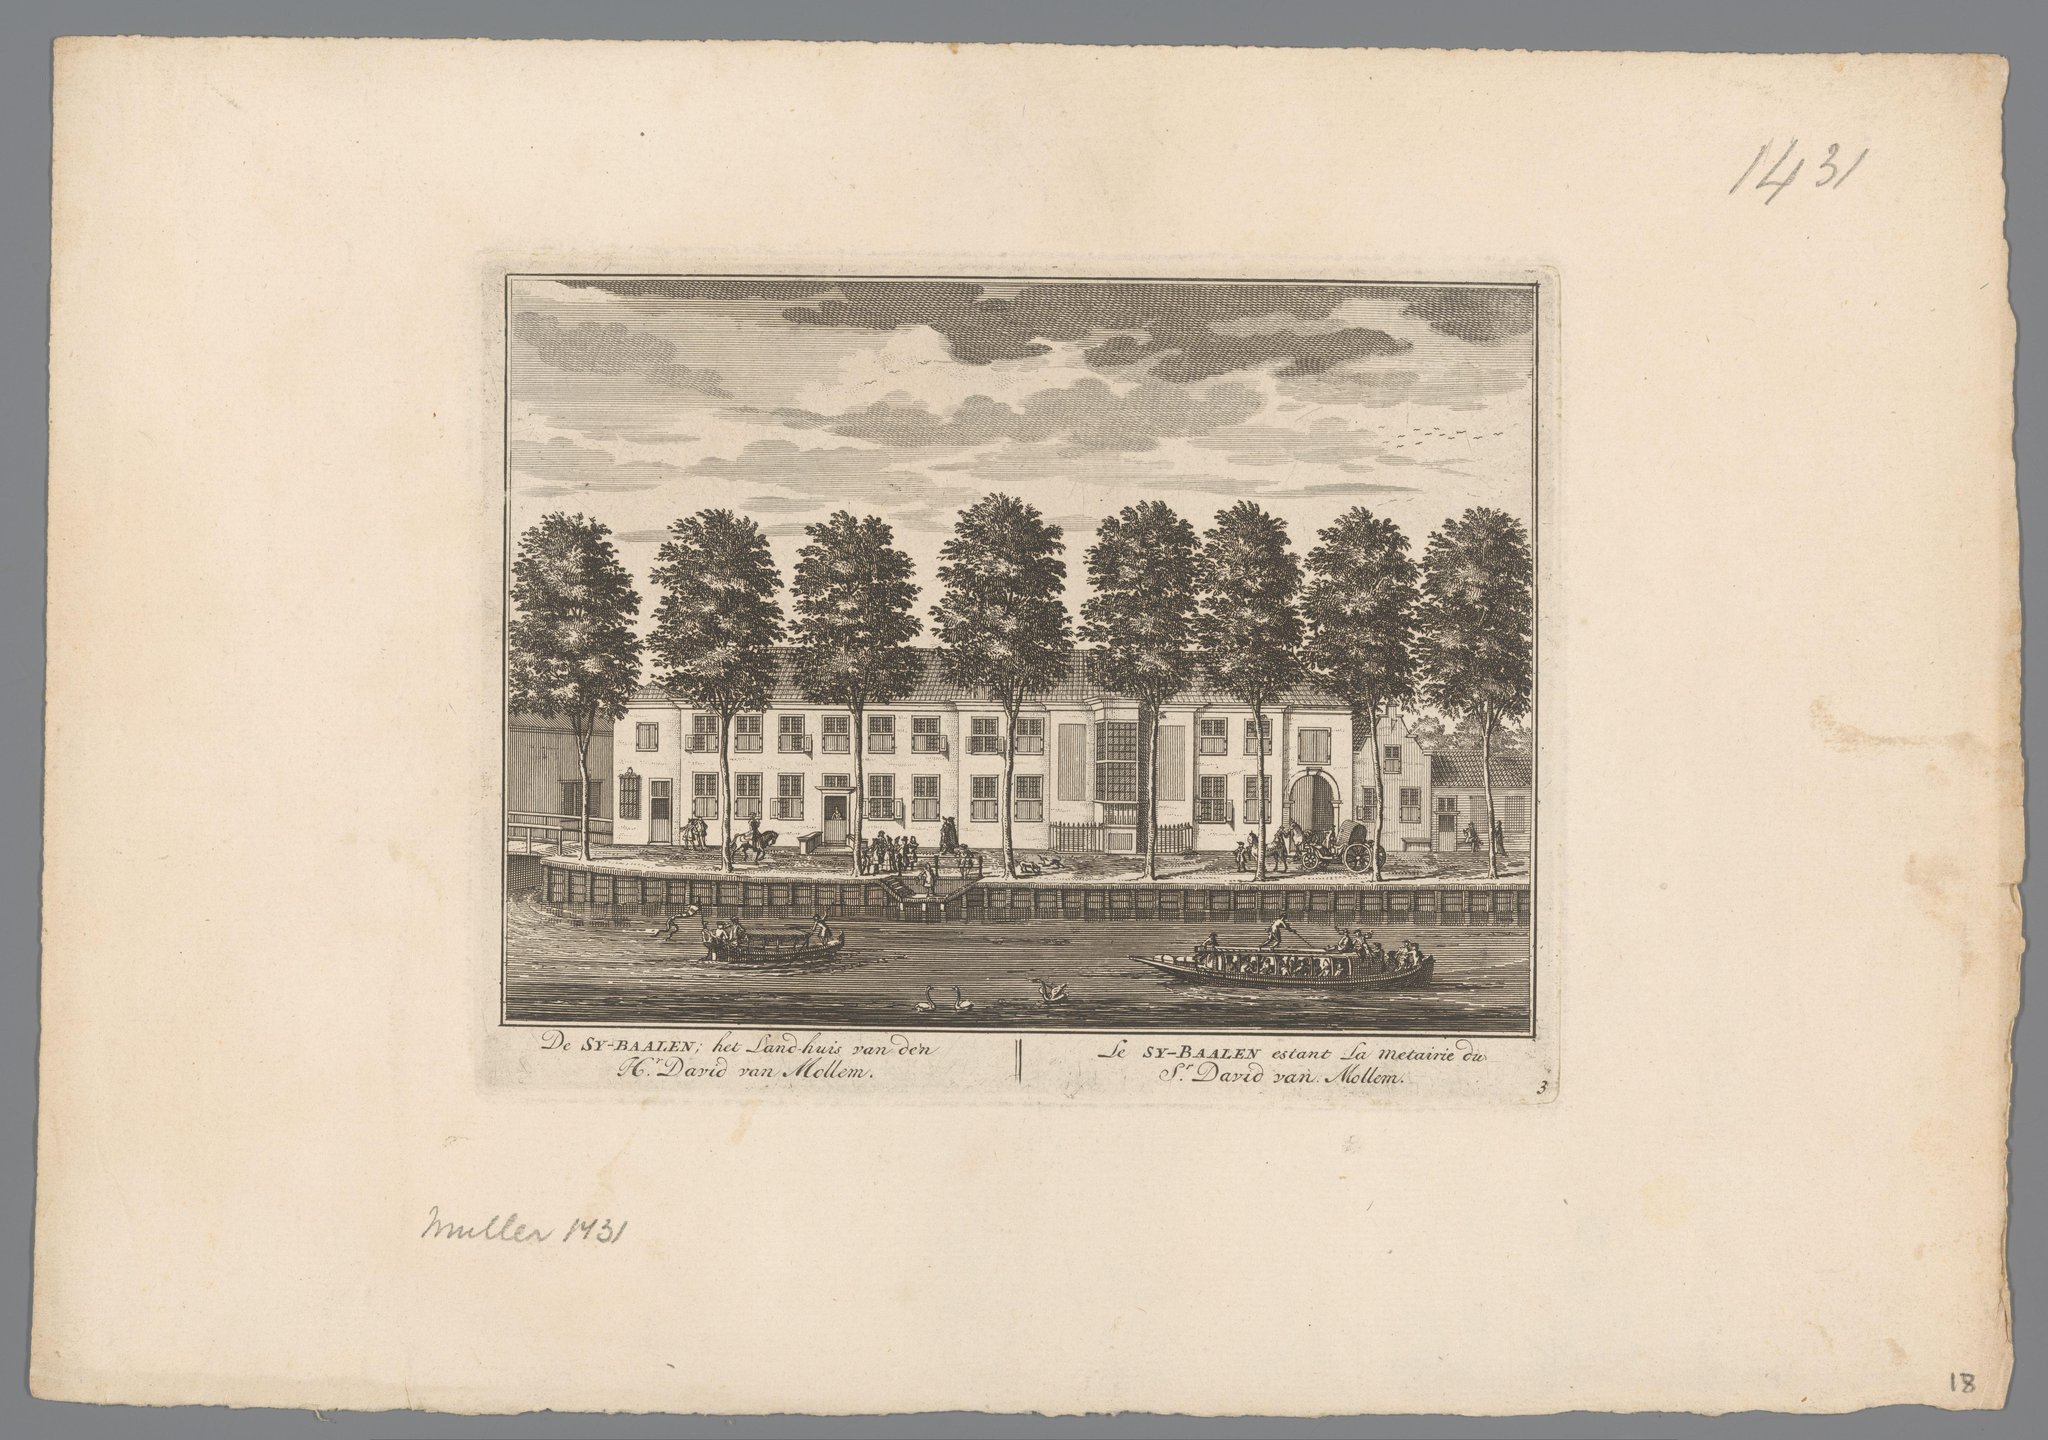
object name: book illustration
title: De Sy-Baalen; het landhuis van den hr. David van Mollem / Le Sy-Baalen estant la metairie du sr. David van Mollem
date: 1719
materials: paper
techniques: engraving, etching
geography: amsterdam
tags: castle, landscape with tower or castle, vecht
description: Prent uit: Leth, Andries de. De Zegepraalende Vecht (...). Amsterdam: Weduwe Nicolaes Visscher, 1719, pl. 3. Later ook uitgegeven in: Brouërius van Nidek, Matthaeus. De Vechtstroom, van Utrecht tot Muiden (...). Amsterdam: H. Gartman, W. Vermandel en J.W. Smit, 1790.